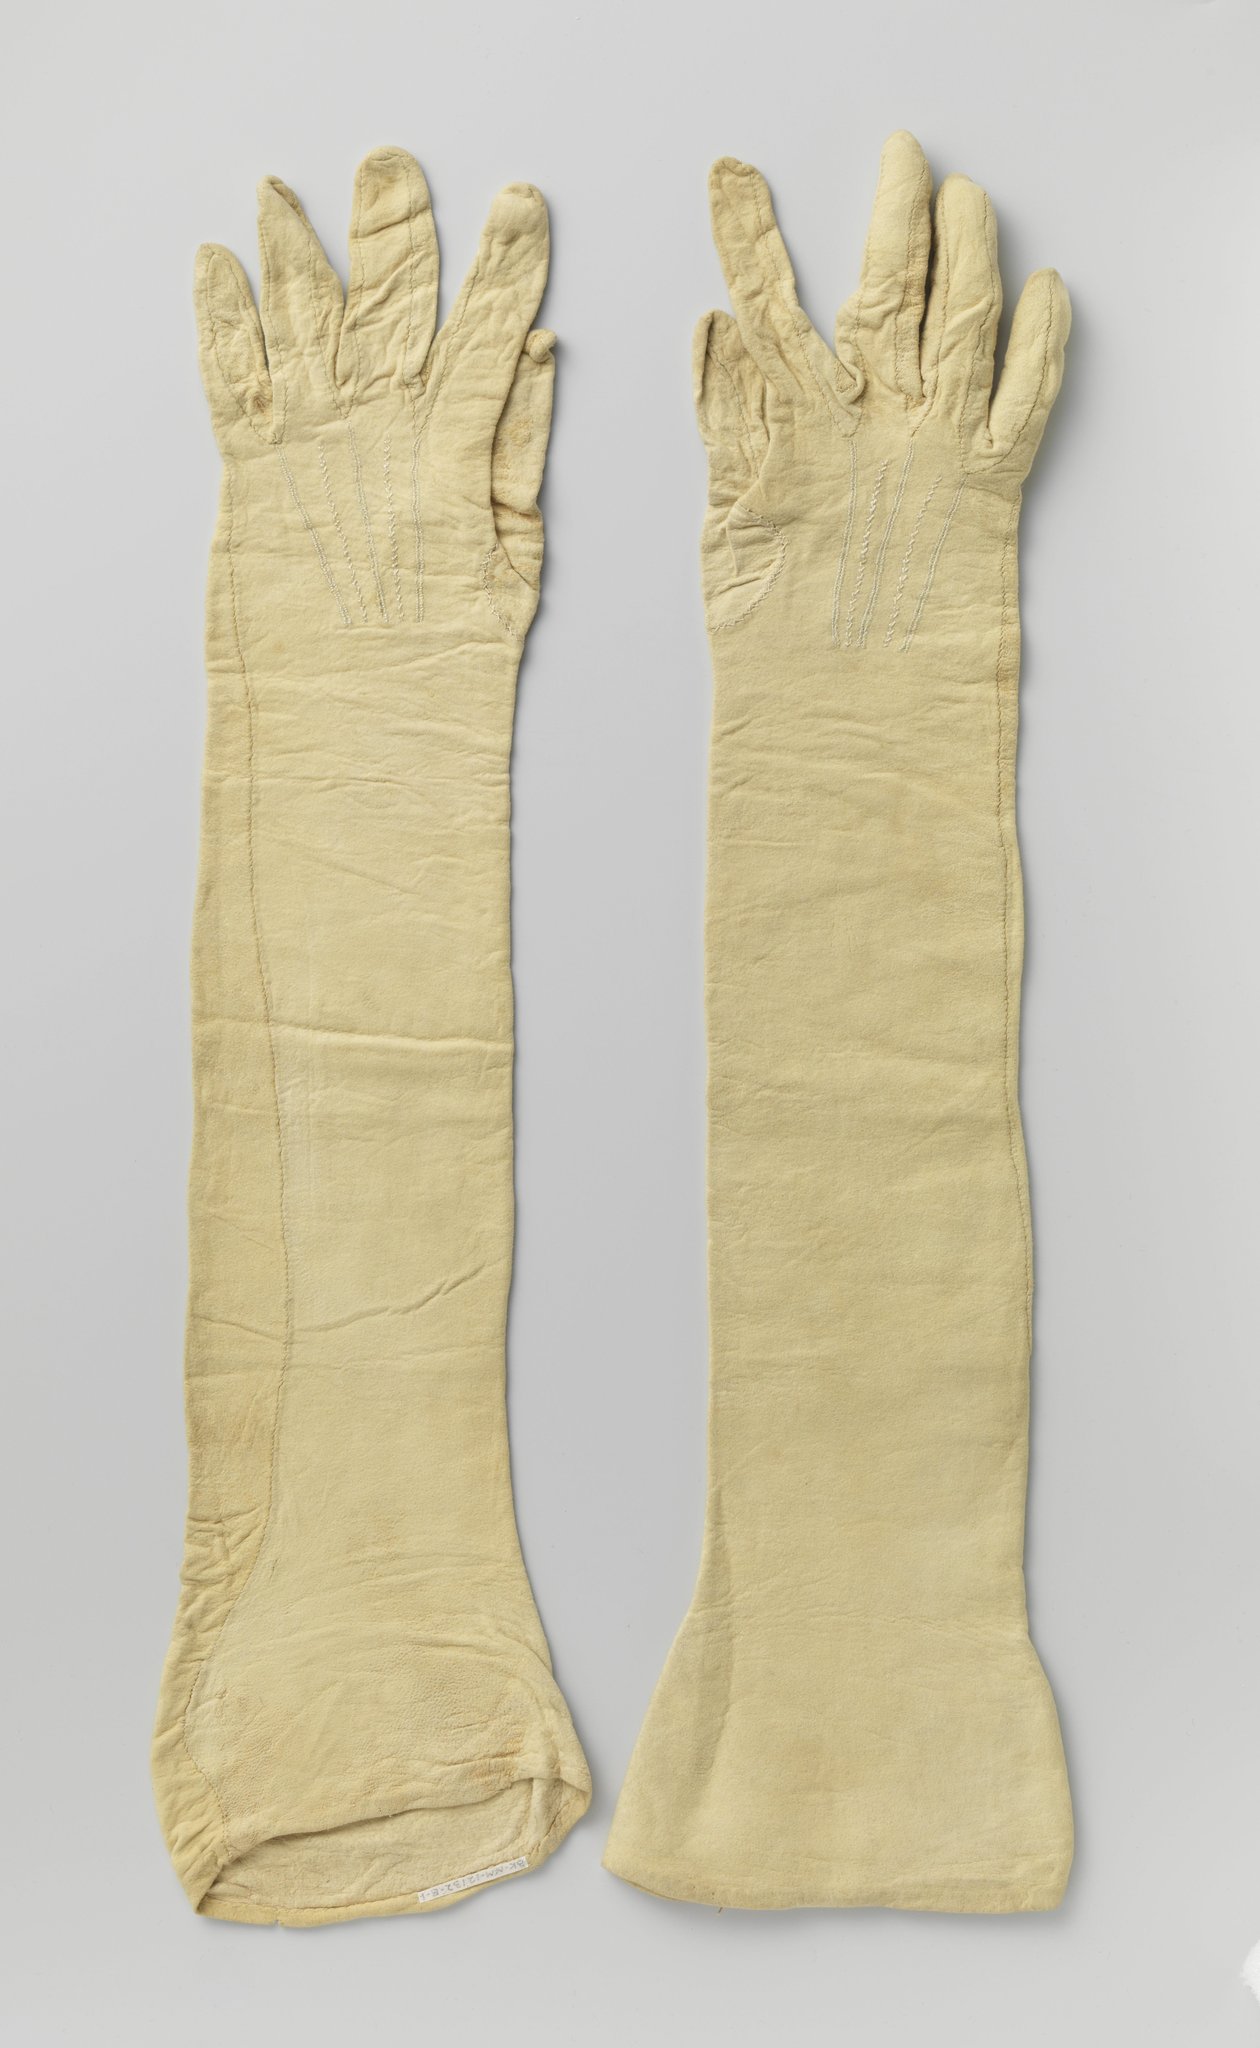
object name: glove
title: Handschoen van beige zeemleer met op de rug vijf geborduurde uitstralende koorden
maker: Anonymous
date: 1800-1850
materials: leather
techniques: embroidered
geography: western europe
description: Linker handschoen van beige zeemleer, met op de rug vijf geborduurde koorden in twee verschillende motiven. lanfs de duim afgezet met flanelsteek.